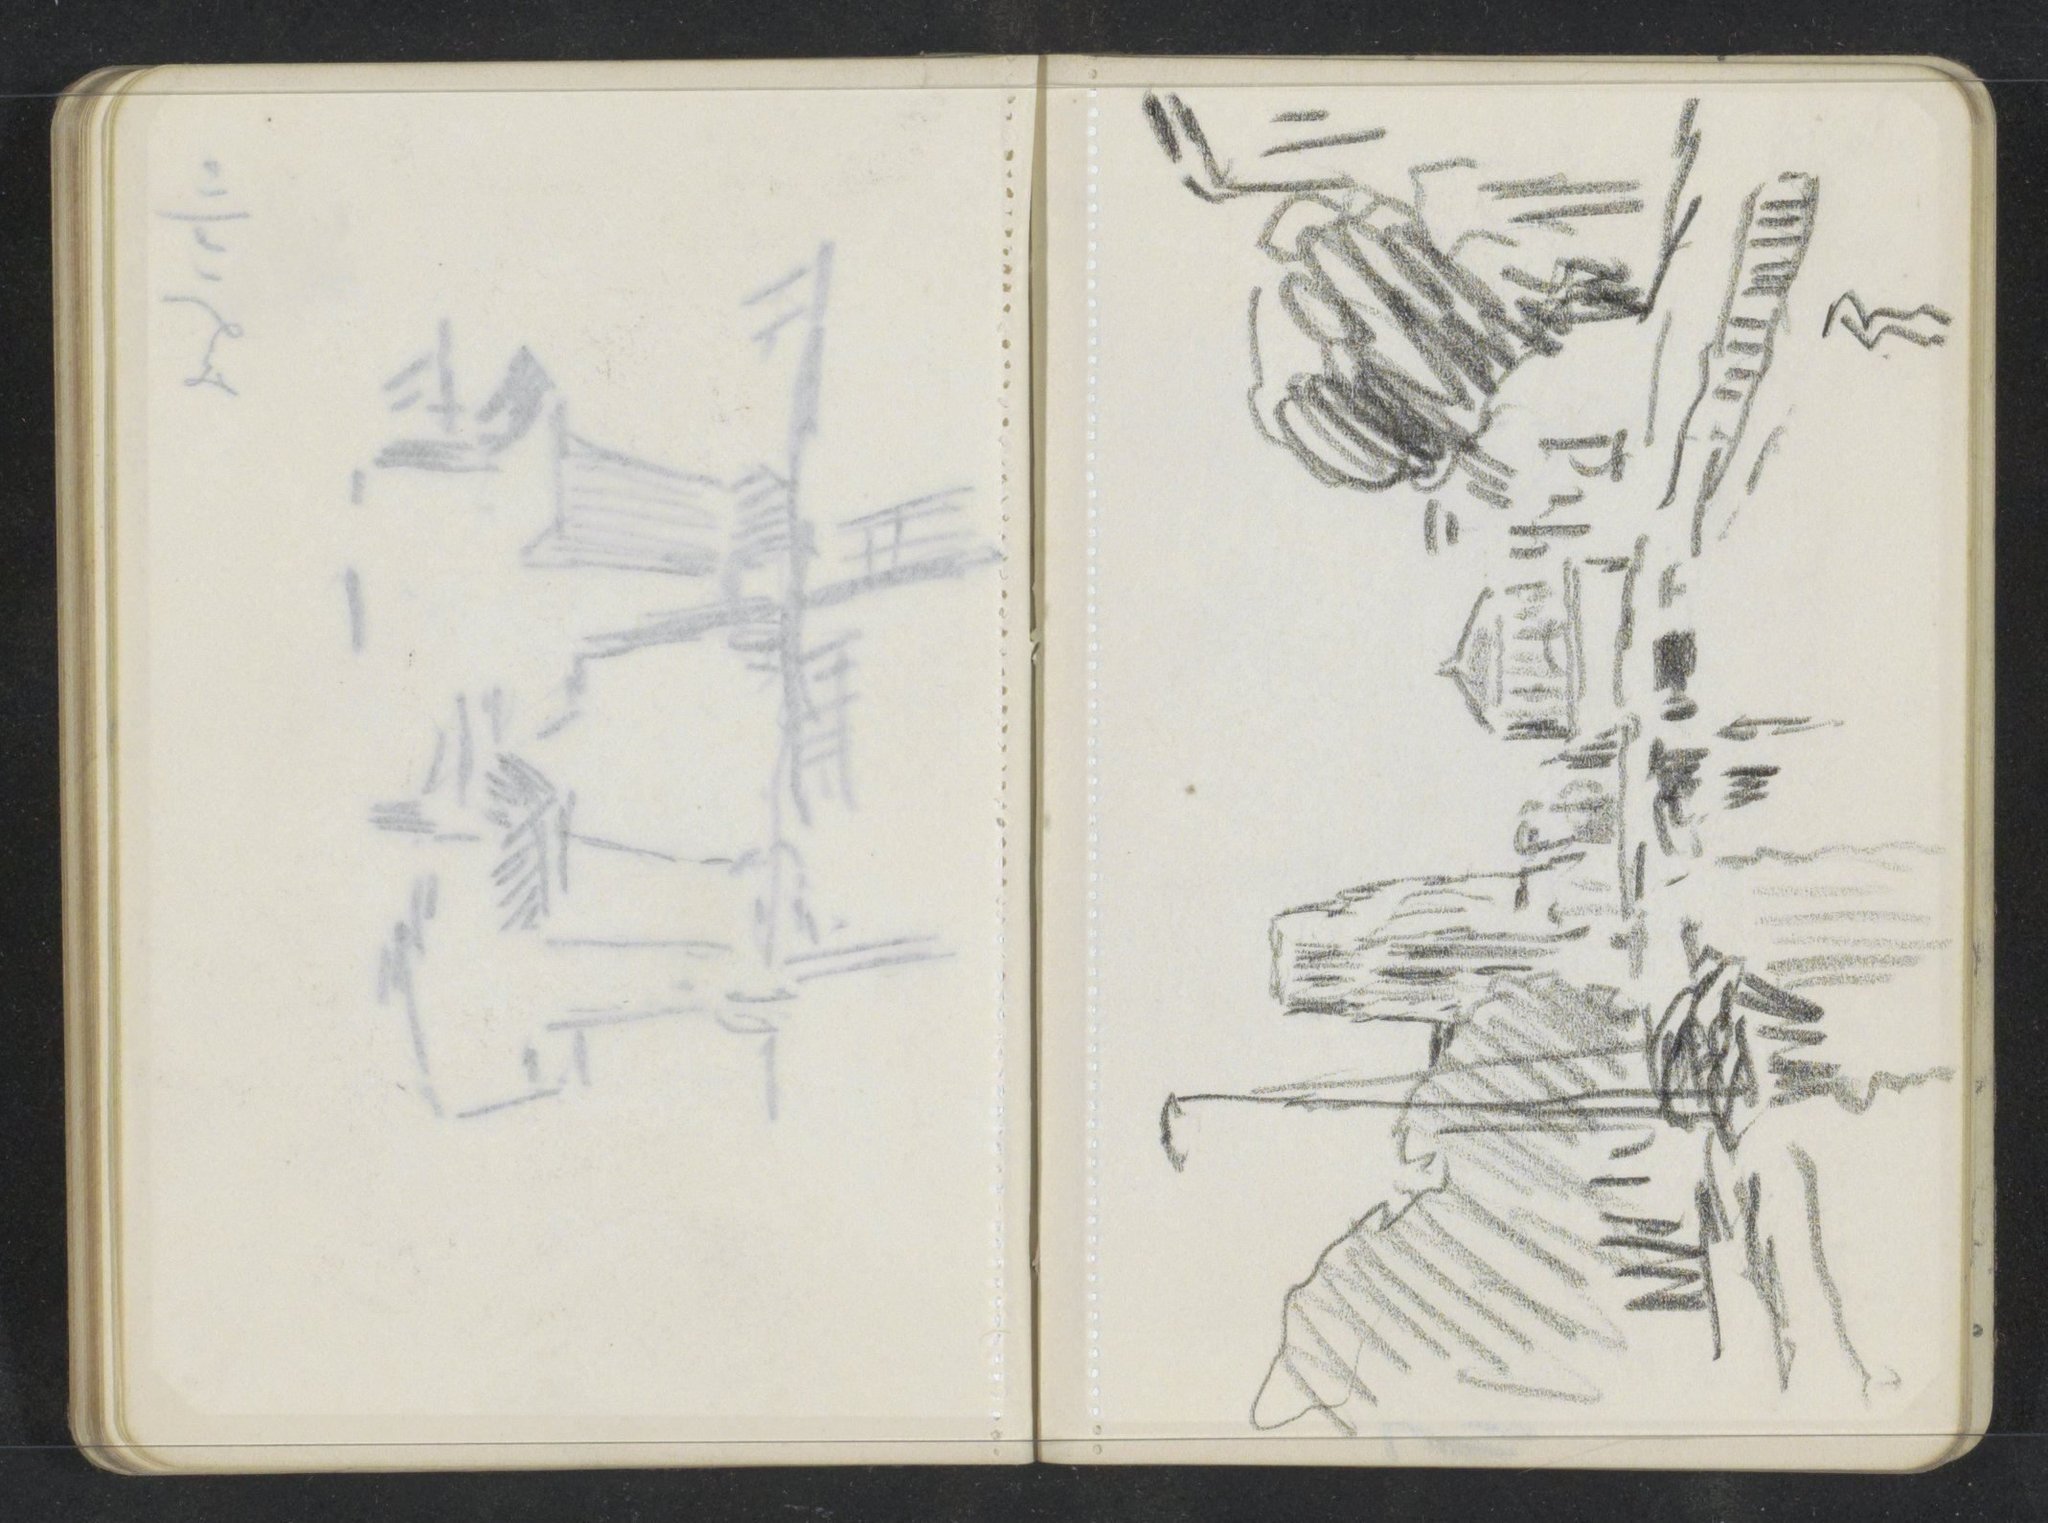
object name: sketchbook leaf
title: Gezicht op een kanaal in een dorp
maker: alexander shilling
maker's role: draughtsman, print maker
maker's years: 1859-1937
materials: chalk, paper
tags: village, canals, waters (in city)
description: Blad 48 recto uit een schetsboek met 91 bladen.